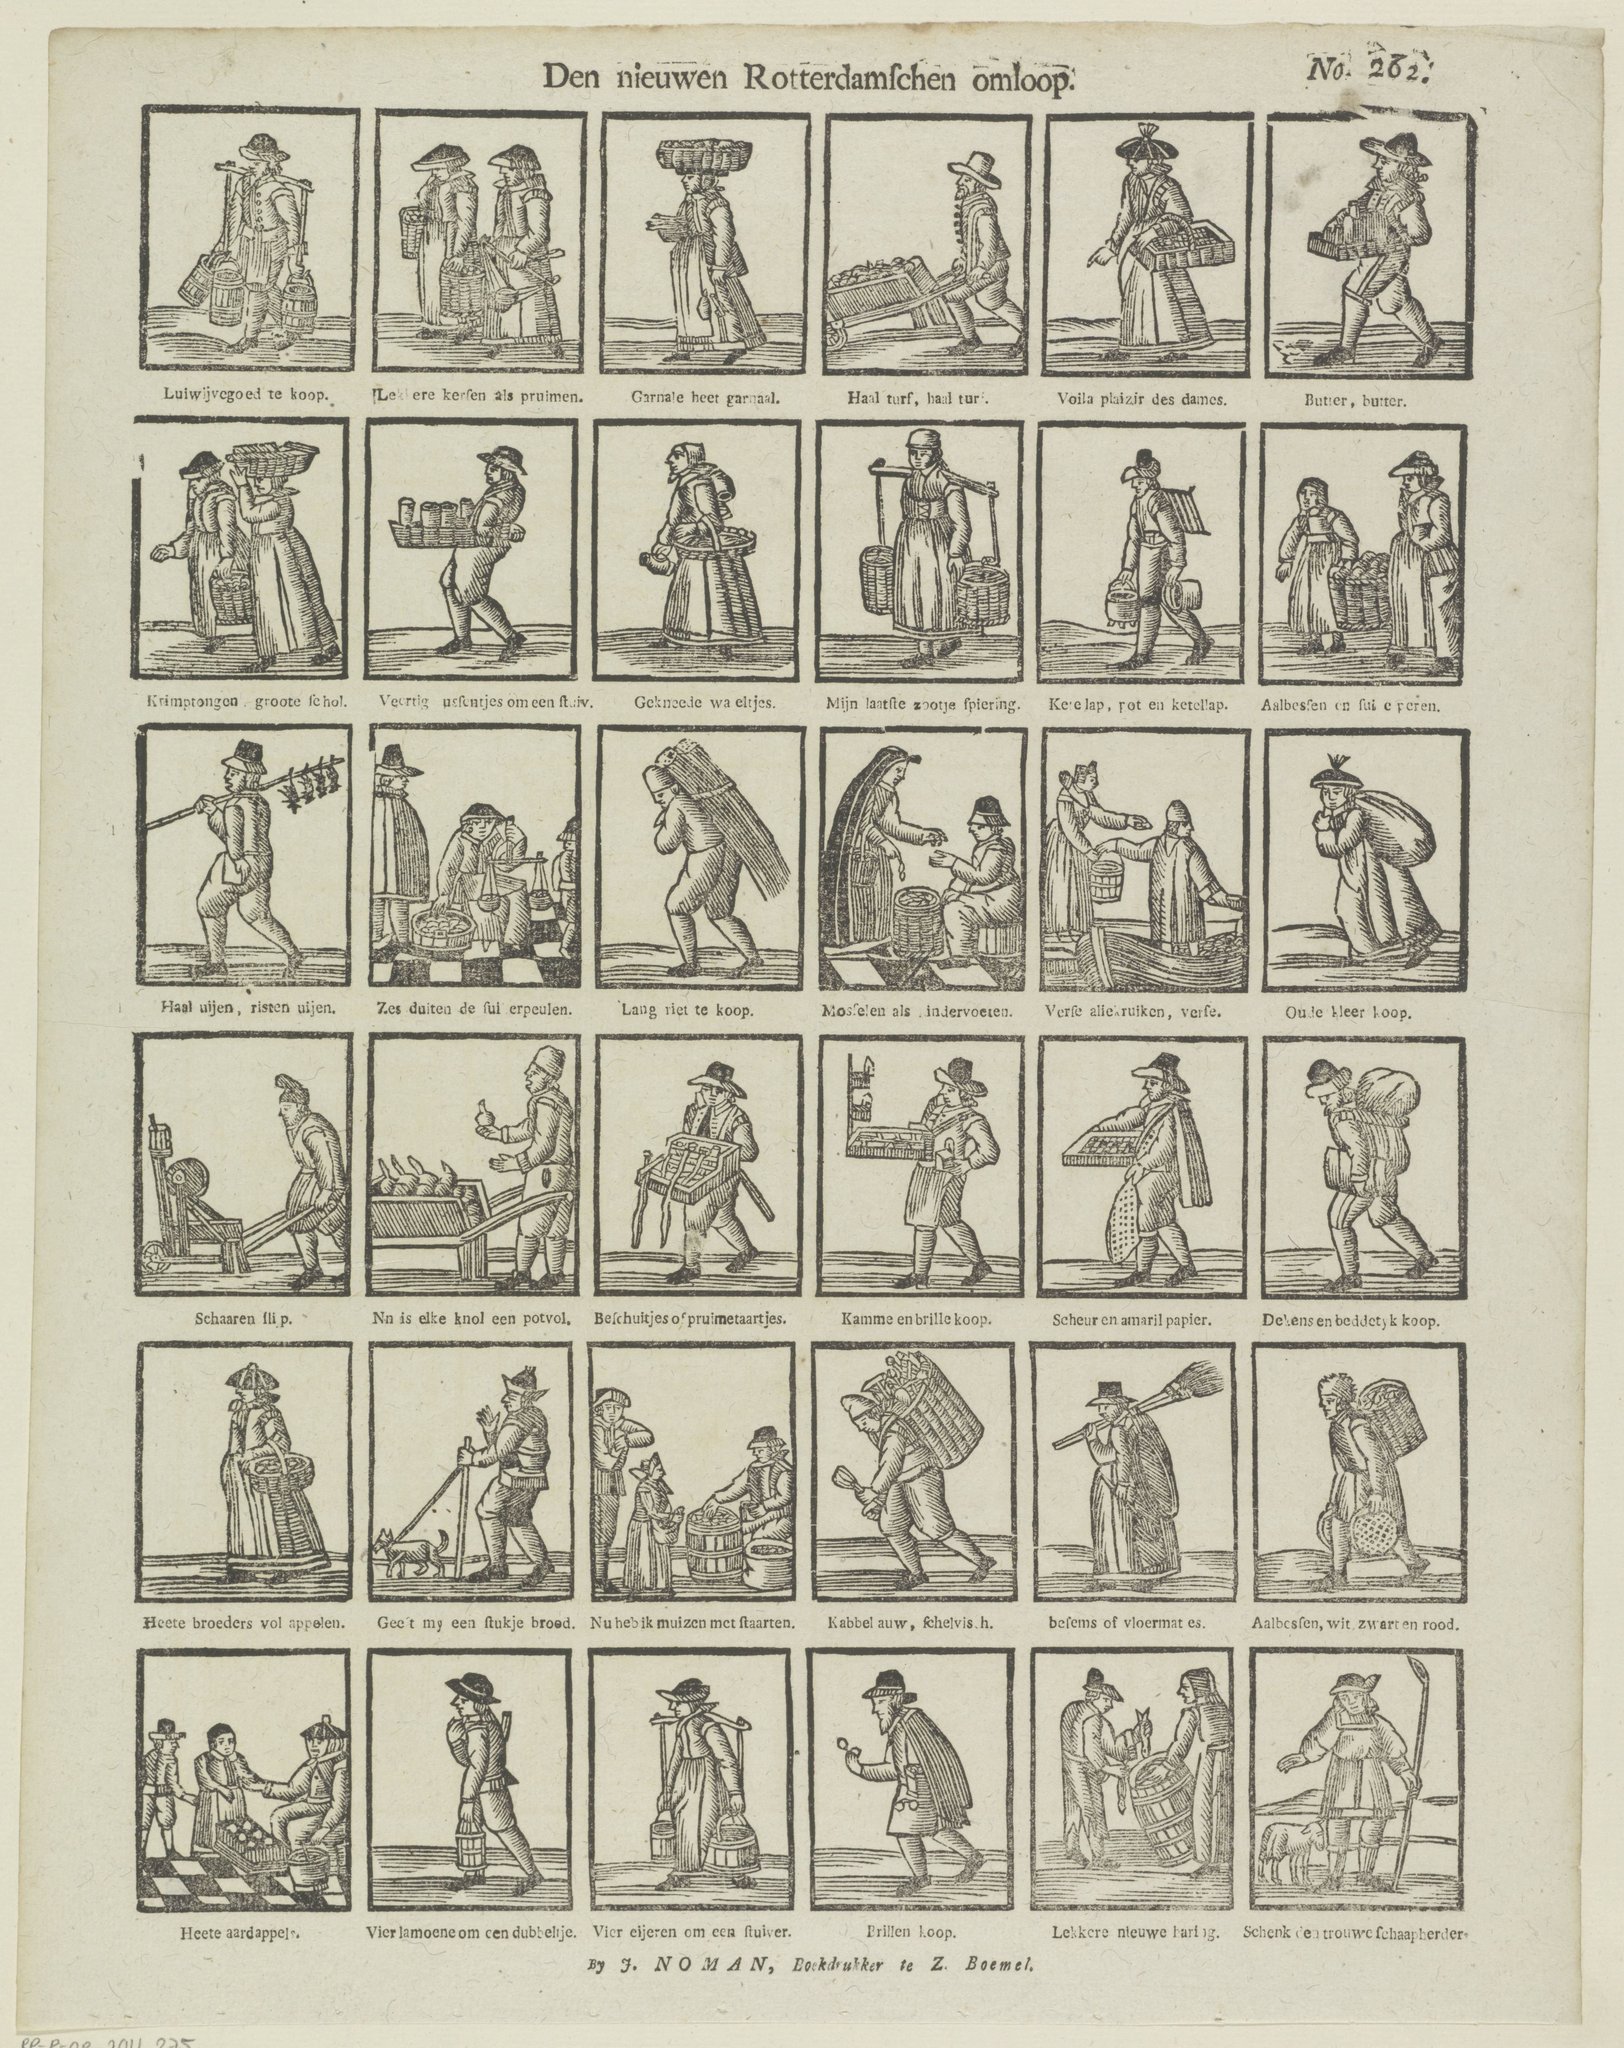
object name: popular print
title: Den nieuwen Rotterdamschen omloop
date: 1806-1830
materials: paper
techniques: letterpress printing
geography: zaltbommel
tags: street-trader, merchant, salesman, rotterdam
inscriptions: collector's mark: Lugt 2760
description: Blad met 36 voorstellingen van Rotterdamse straatverkopers, zoals een garnalenverkoopster, een boterverkoper en een brillenverkoper. Onder elke afbeelding een onderschrift. Genummerd rechtsboven: No. 262.